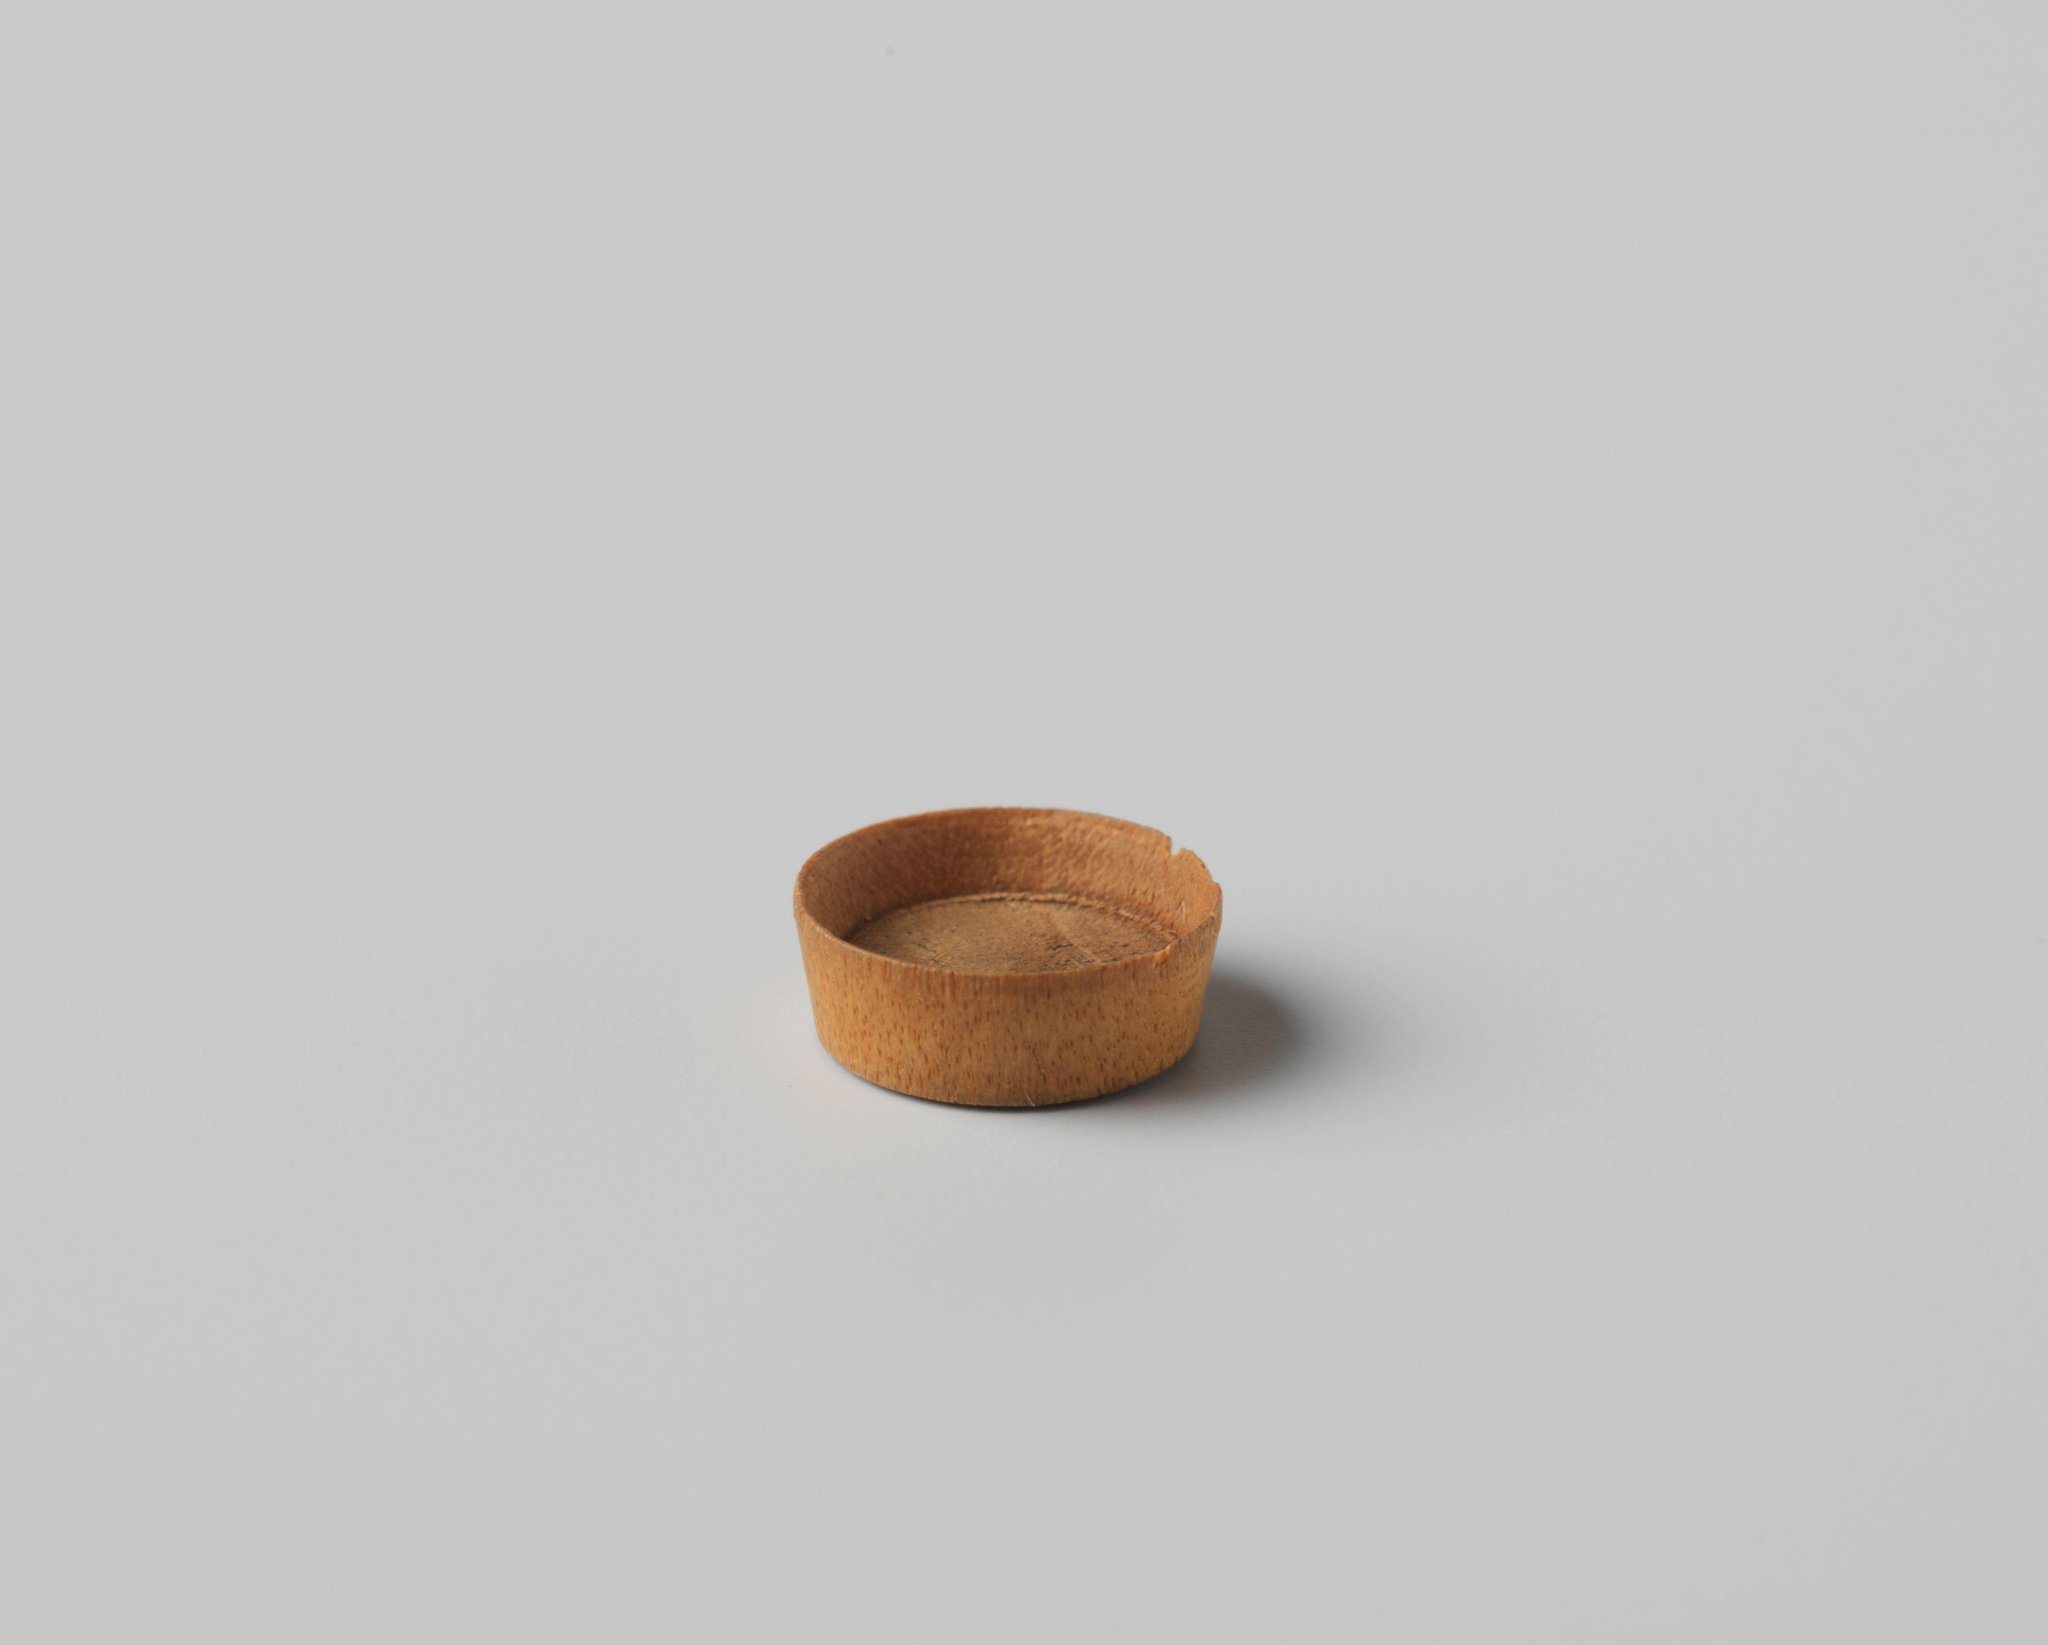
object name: container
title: Bak van hout, rond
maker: Anonymous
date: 1700-1799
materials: without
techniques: without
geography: amsterdam